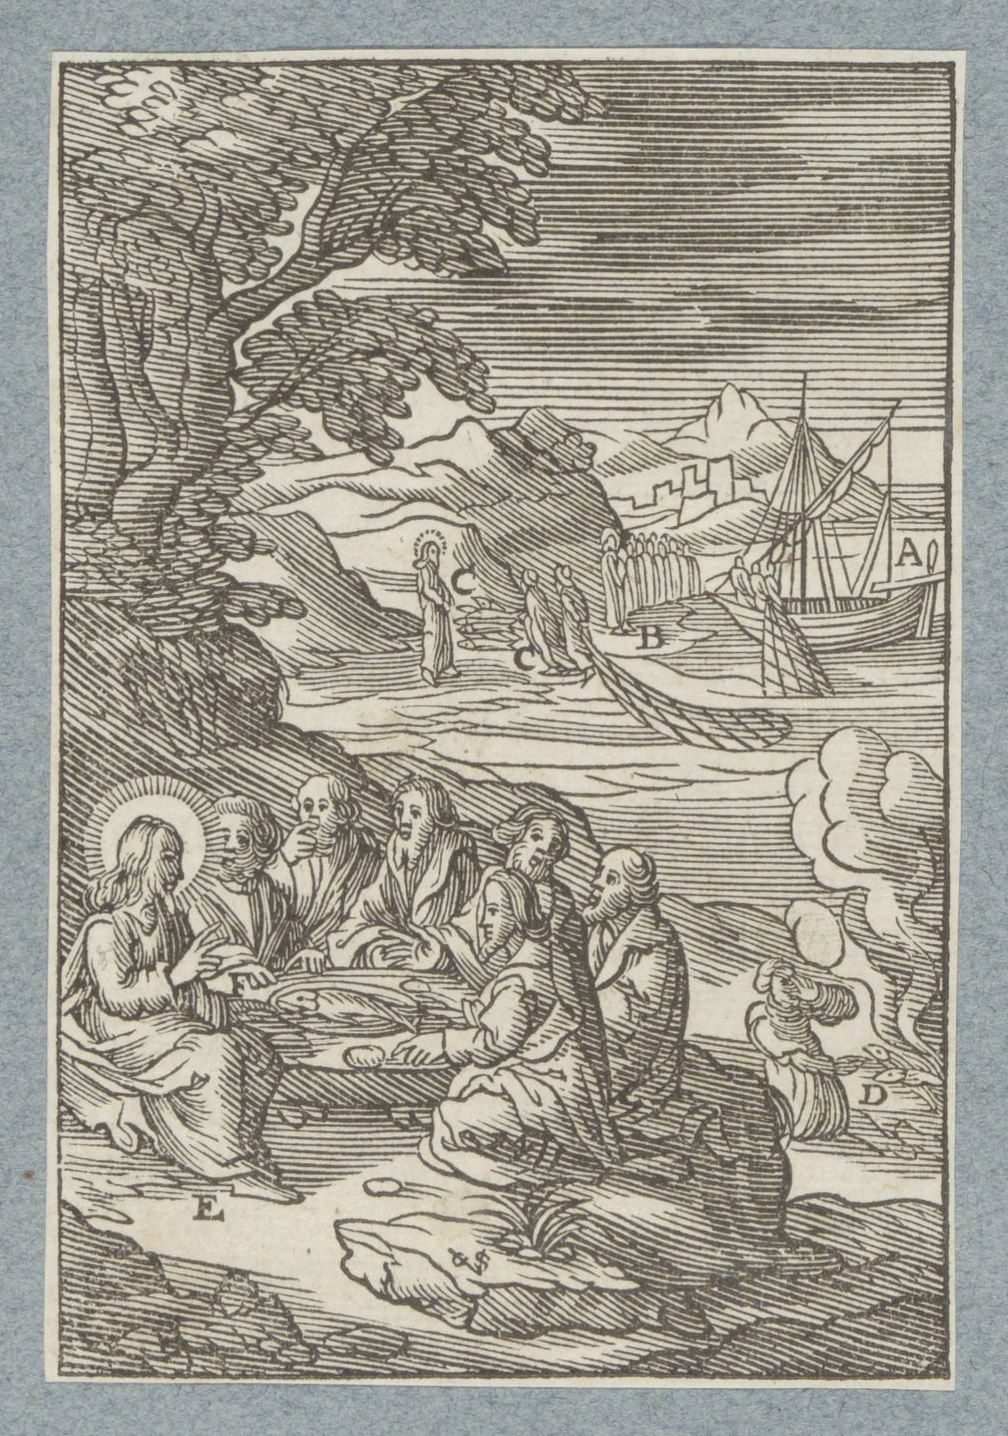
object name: book illustration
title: Christus geeft de sleutels van de hemel aan Petrus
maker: christoffel van sichem (ii)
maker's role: print maker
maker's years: 1581-1658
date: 1629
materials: paper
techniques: letterpress printing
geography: amsterdam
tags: christ gives fish and bread to the apostles, appearance of christ at the lake of gennesaret (sea of galilee, sea of tiberias): miraculous draught of fishes (after the resurrection)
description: De prent is afkomstig uit een van de uitgaven van P.J. Paets uit Amsterdam. De prent wordt voor het eerst gebruikt in: Der Zielen Lust-hof. Leuven, I.Jacbosz voor P.J. Paets [= Amsterdam, P.J. Paets], 1629. De voorstelling is gekopieerd naar een prent van Antonie II Wierix voor: Nadal, Jerónimo. Evangelicae Historiae Imagines. Antwerpen, M. Nutius, 1593.